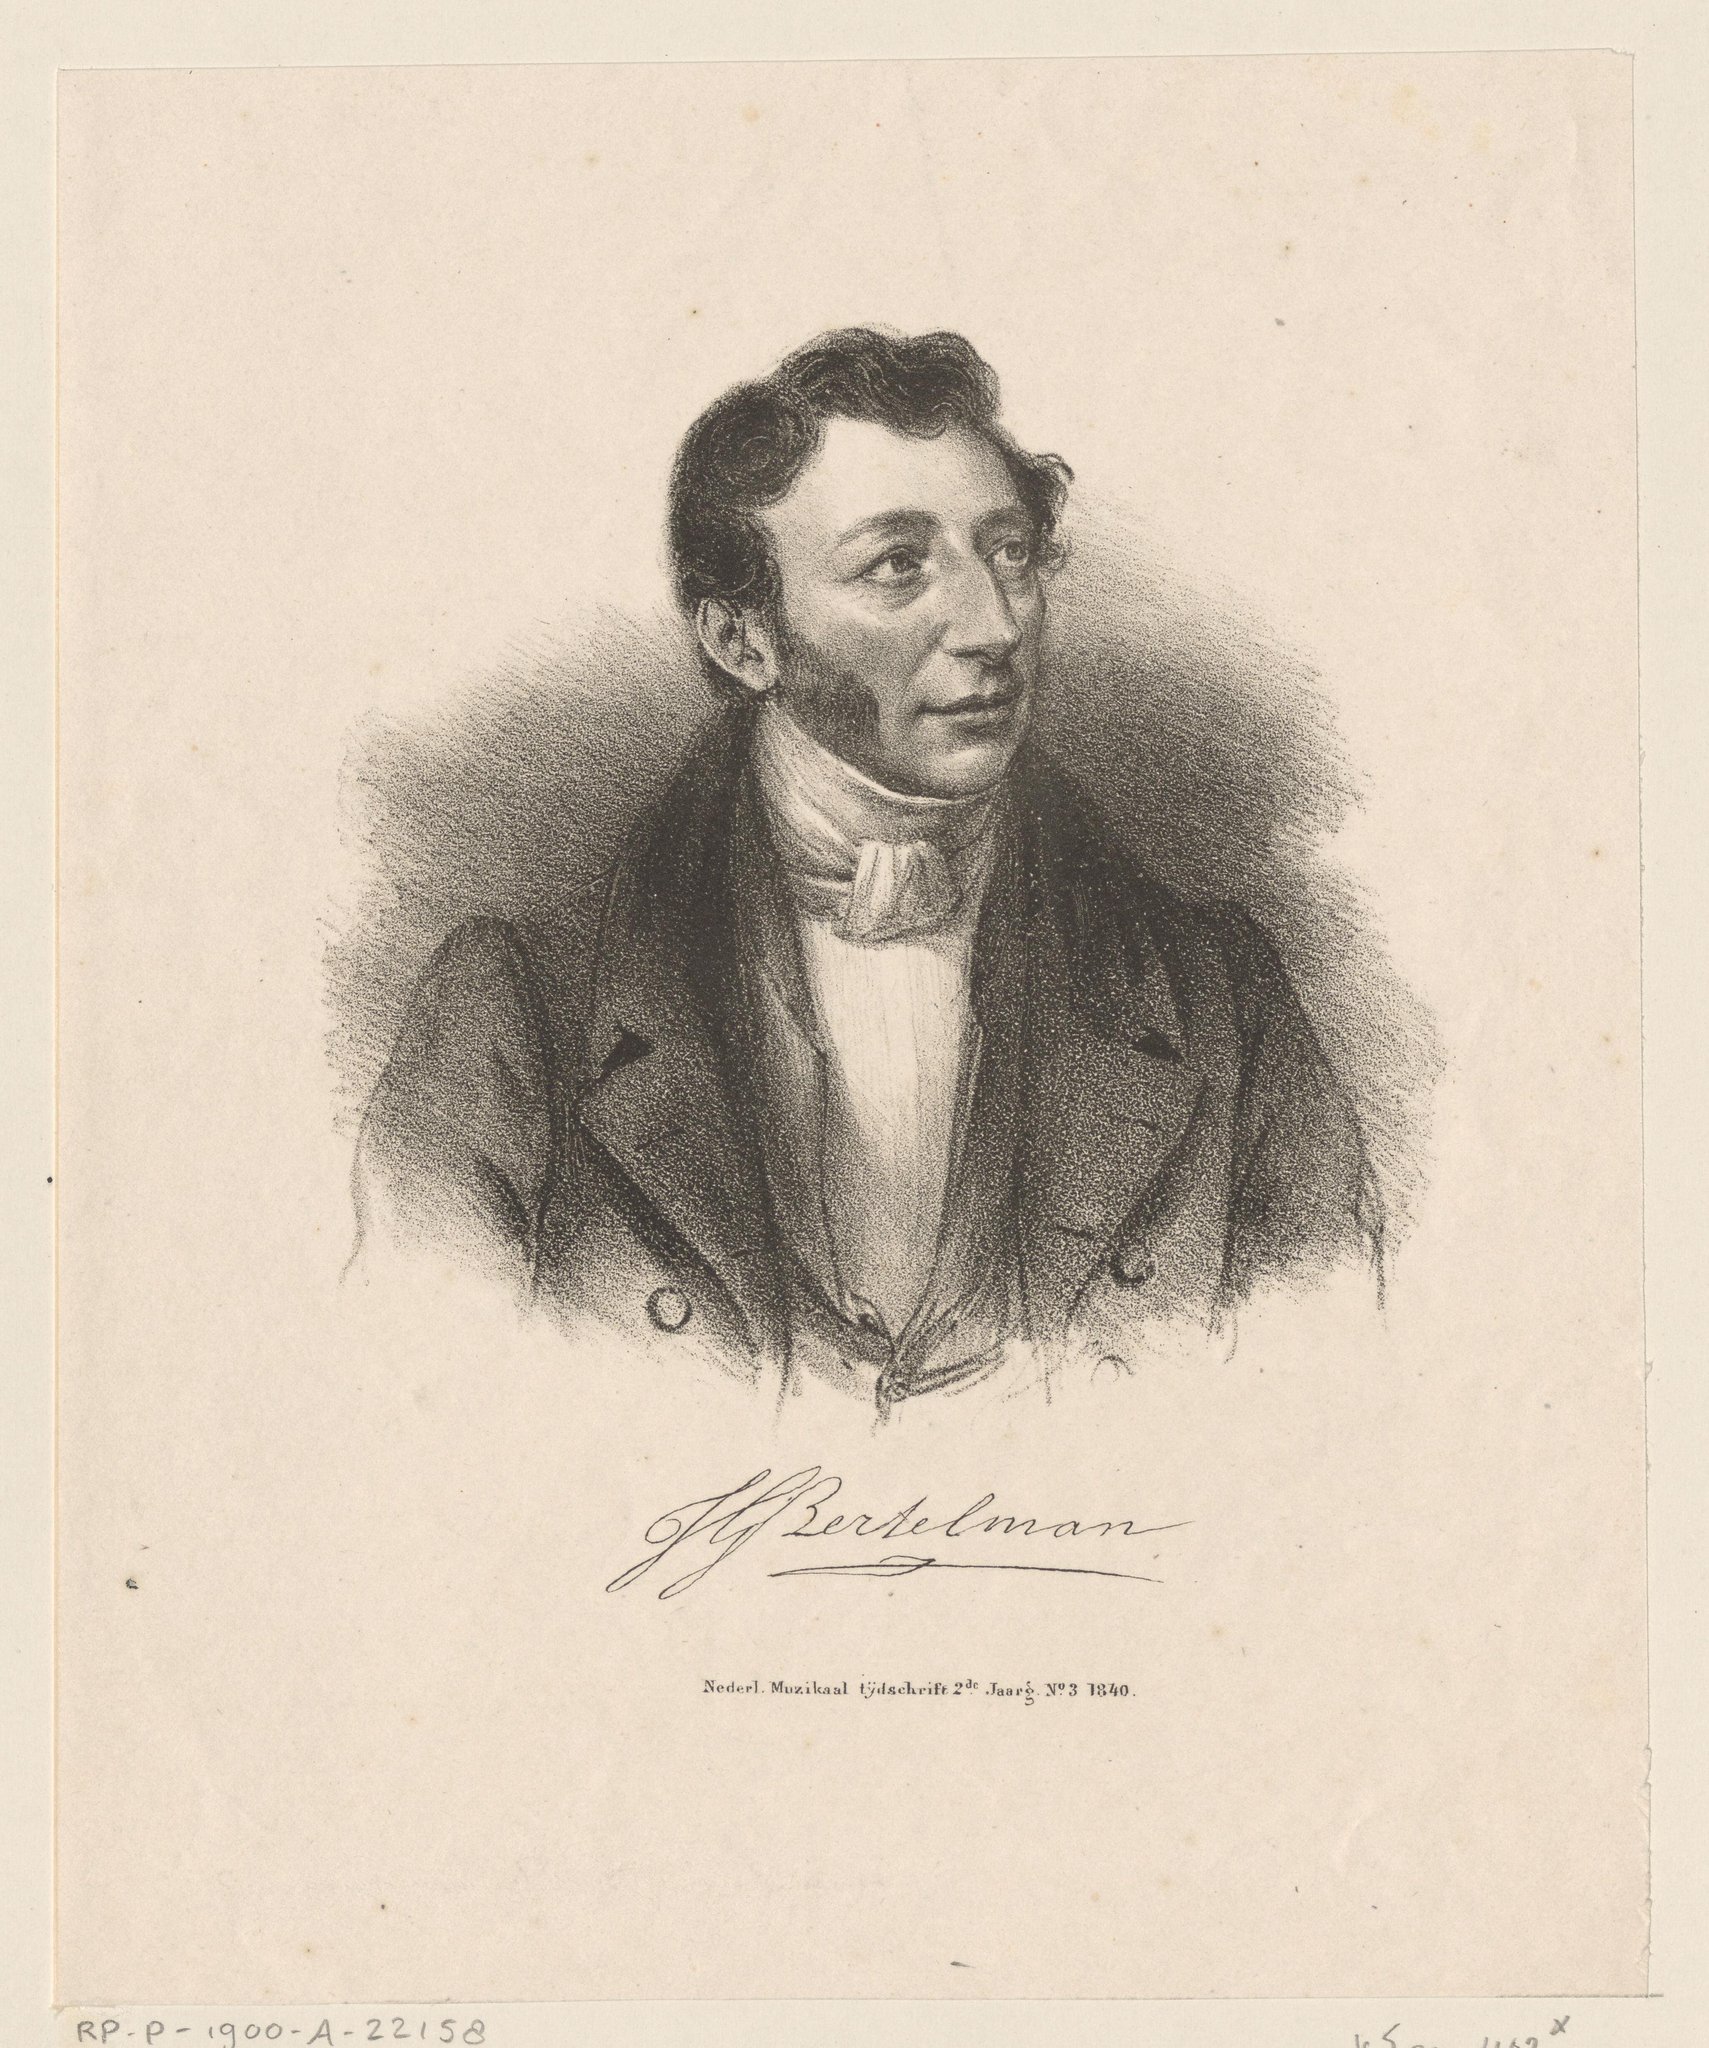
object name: print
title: Portret van Jan George Bertelman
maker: Anonymous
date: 1840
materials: paper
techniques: lithograph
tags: amsterdam, historical persons, portrait of composer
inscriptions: collector's mark: Lugt 2228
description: Prent uit: Nederlandsch muzikaal tijdschrift (1840), nr. 2, 1840.